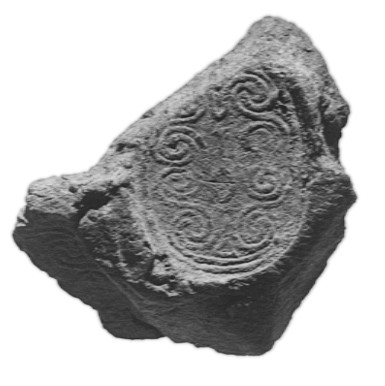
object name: sealing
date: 2030-1640 BCE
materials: clay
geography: egypt